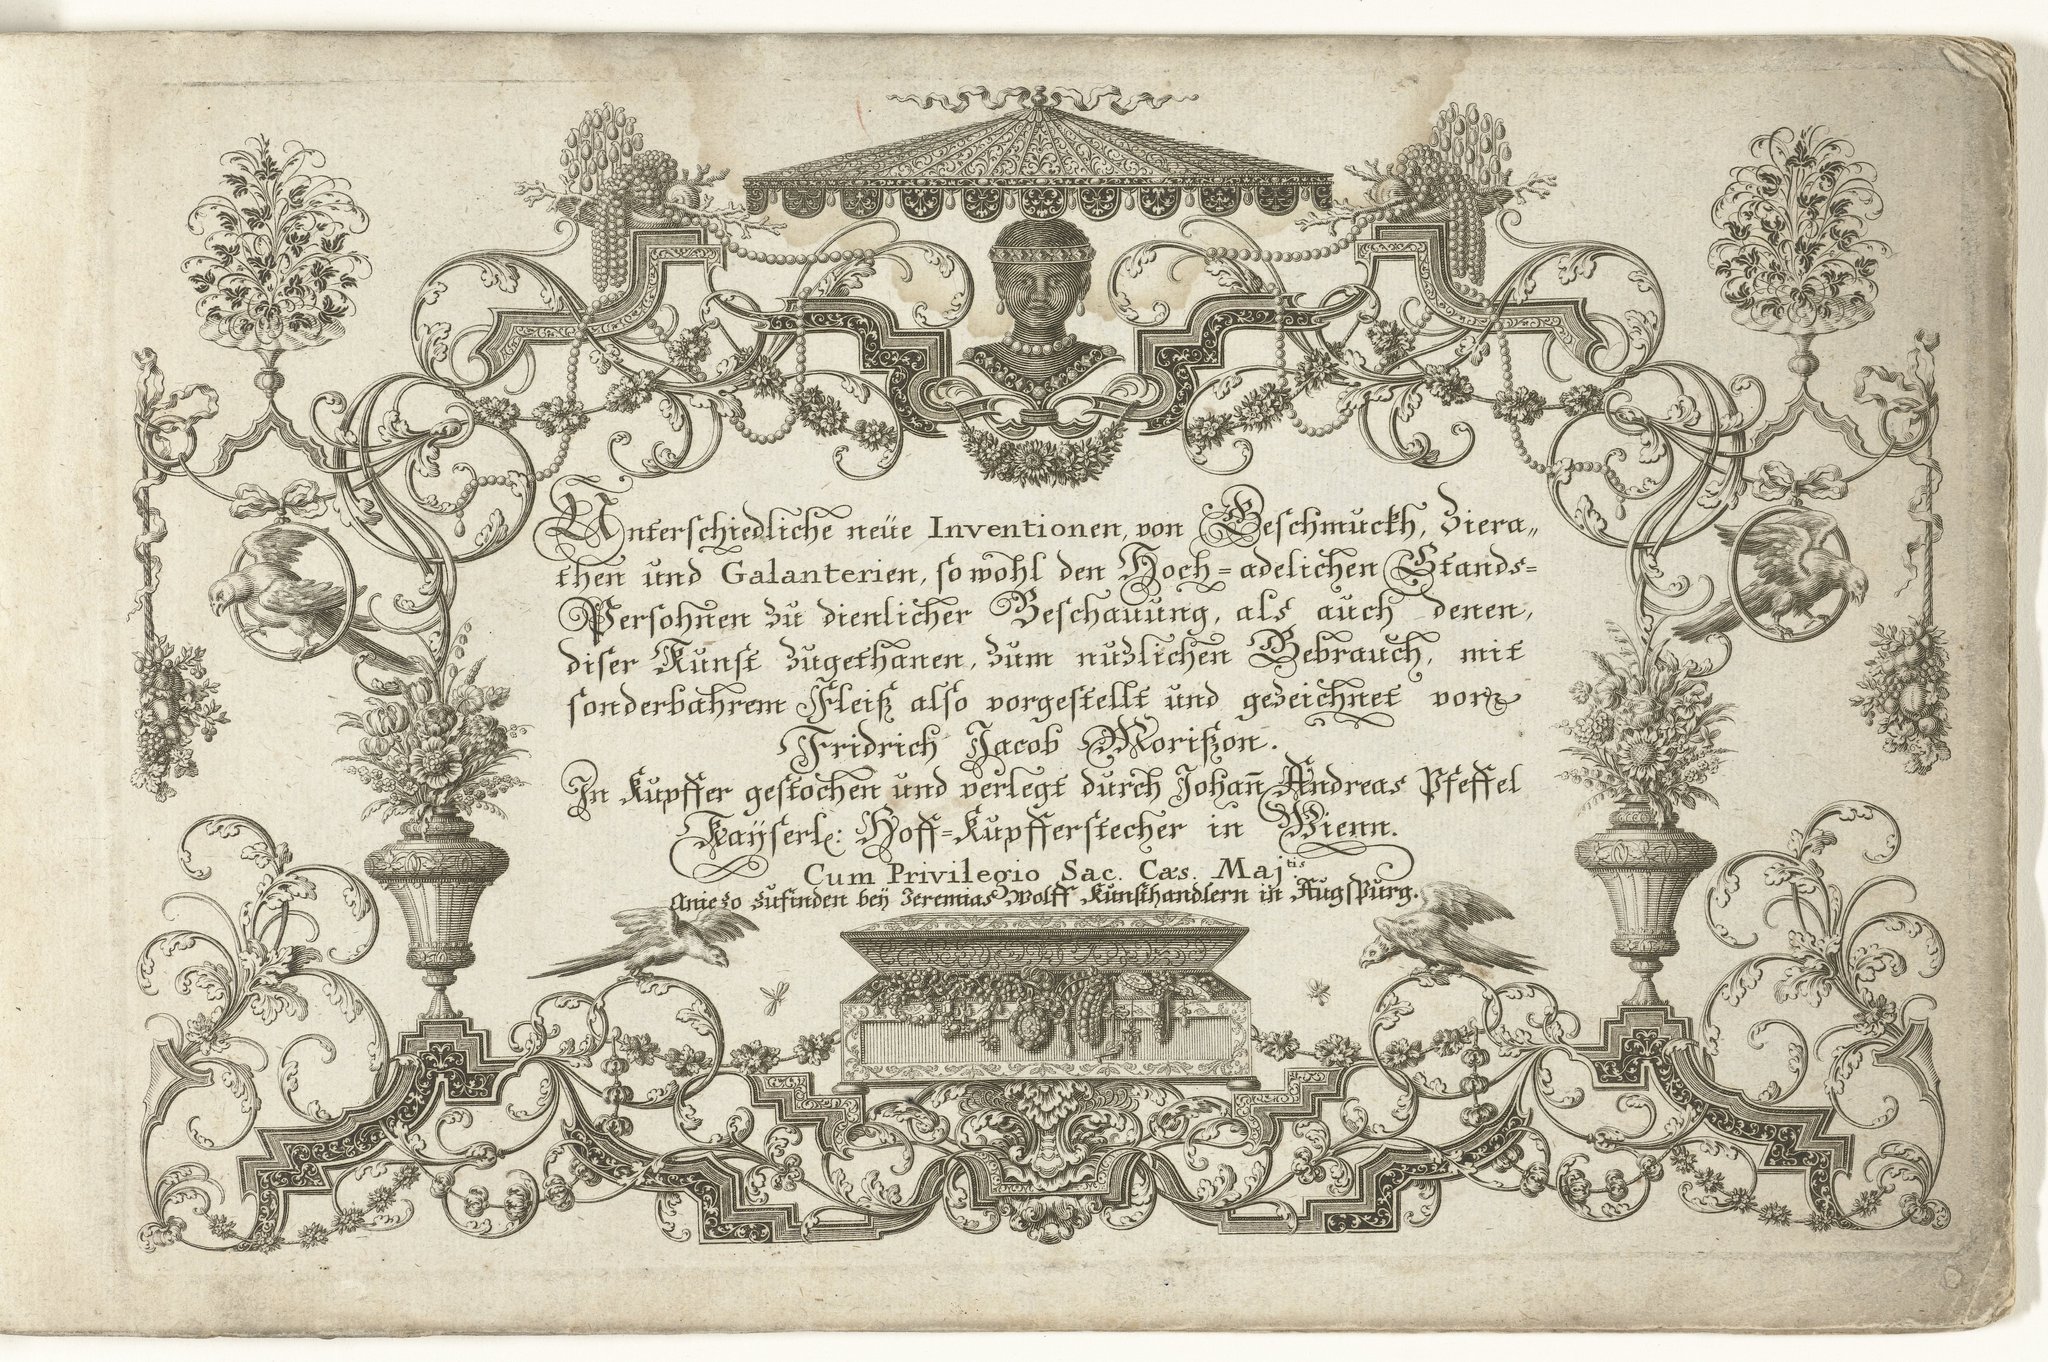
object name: print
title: Titelblad: Unterschiedliche neüe Inventionen,von Geschmuckh, Zierathen und Galanterien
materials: paper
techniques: engraving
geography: augsburg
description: Lijst van bladranken en randen met bloemenvazen, bovenaan het hoofd van een moor onder een parasol. Titelblad uit serie van 8 bladen met ontwerpen voor juwelen met parels en edelstenen. Tweede editie.